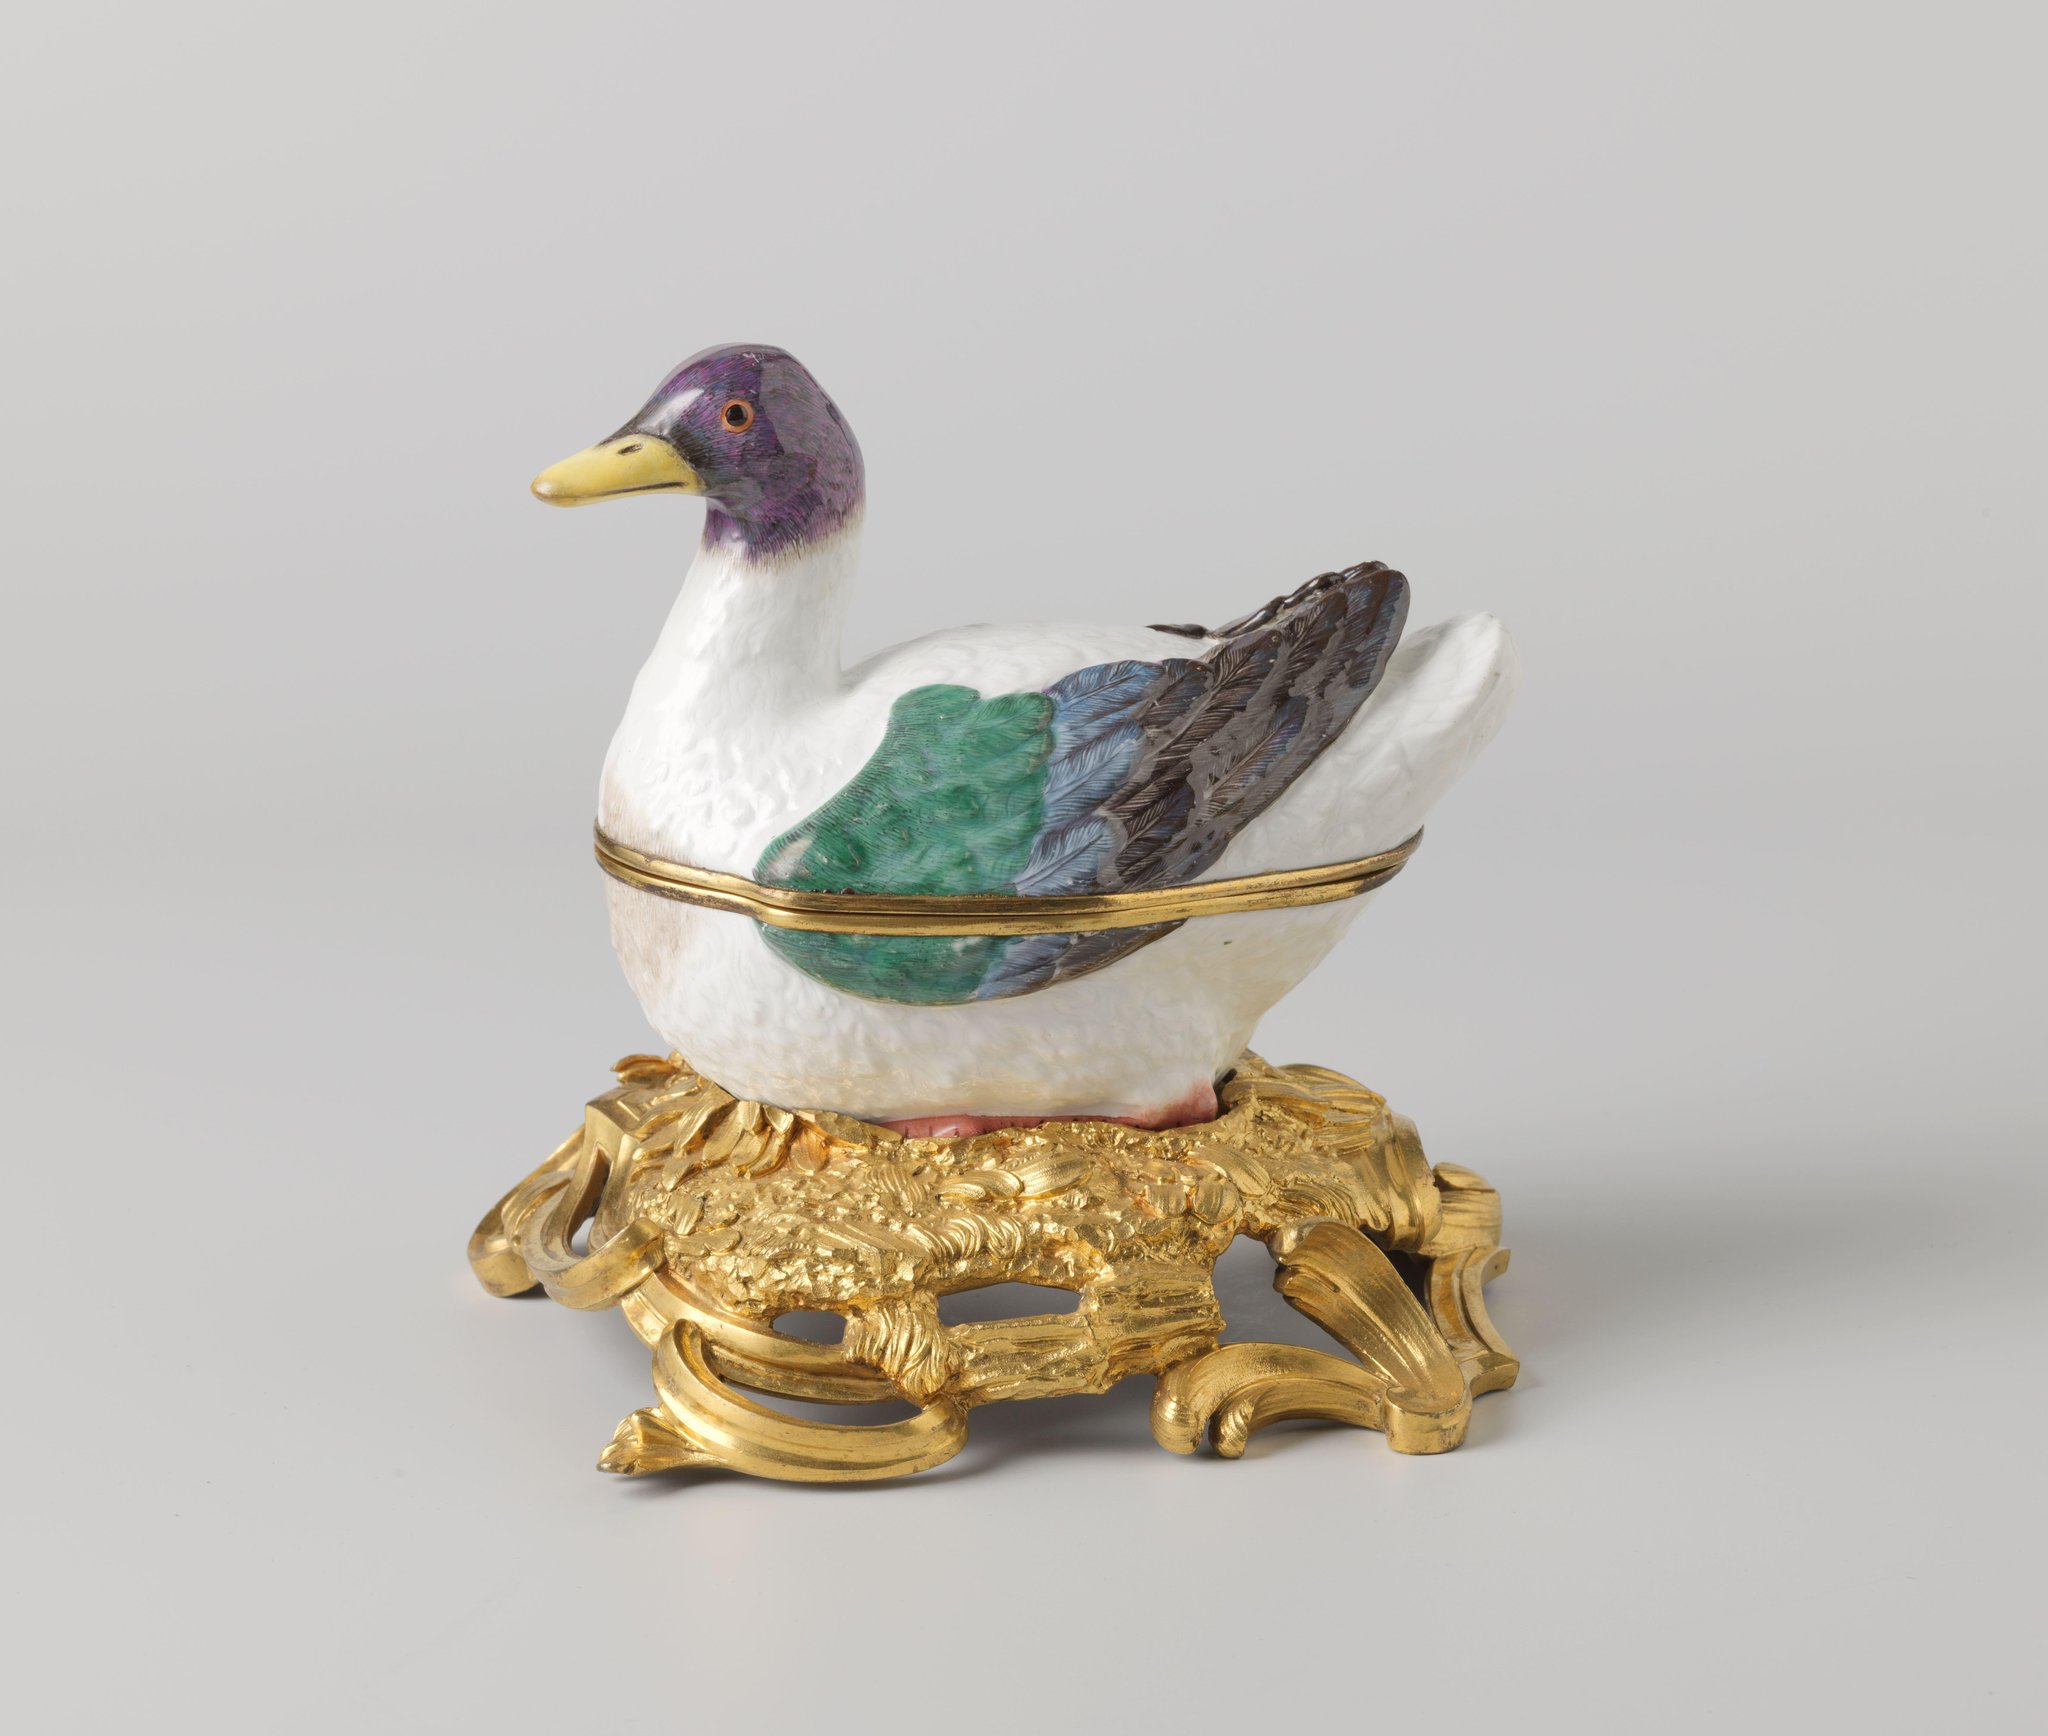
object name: base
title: Verguld bronzen rococo-voetstuk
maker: johann joachim kändler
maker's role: designer, sculptor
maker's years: 1706-1775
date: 1740-1748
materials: bronze, porcelain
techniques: gilding, painted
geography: meissen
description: De eend zit op een verguld bronzen rococo-voetstuk.